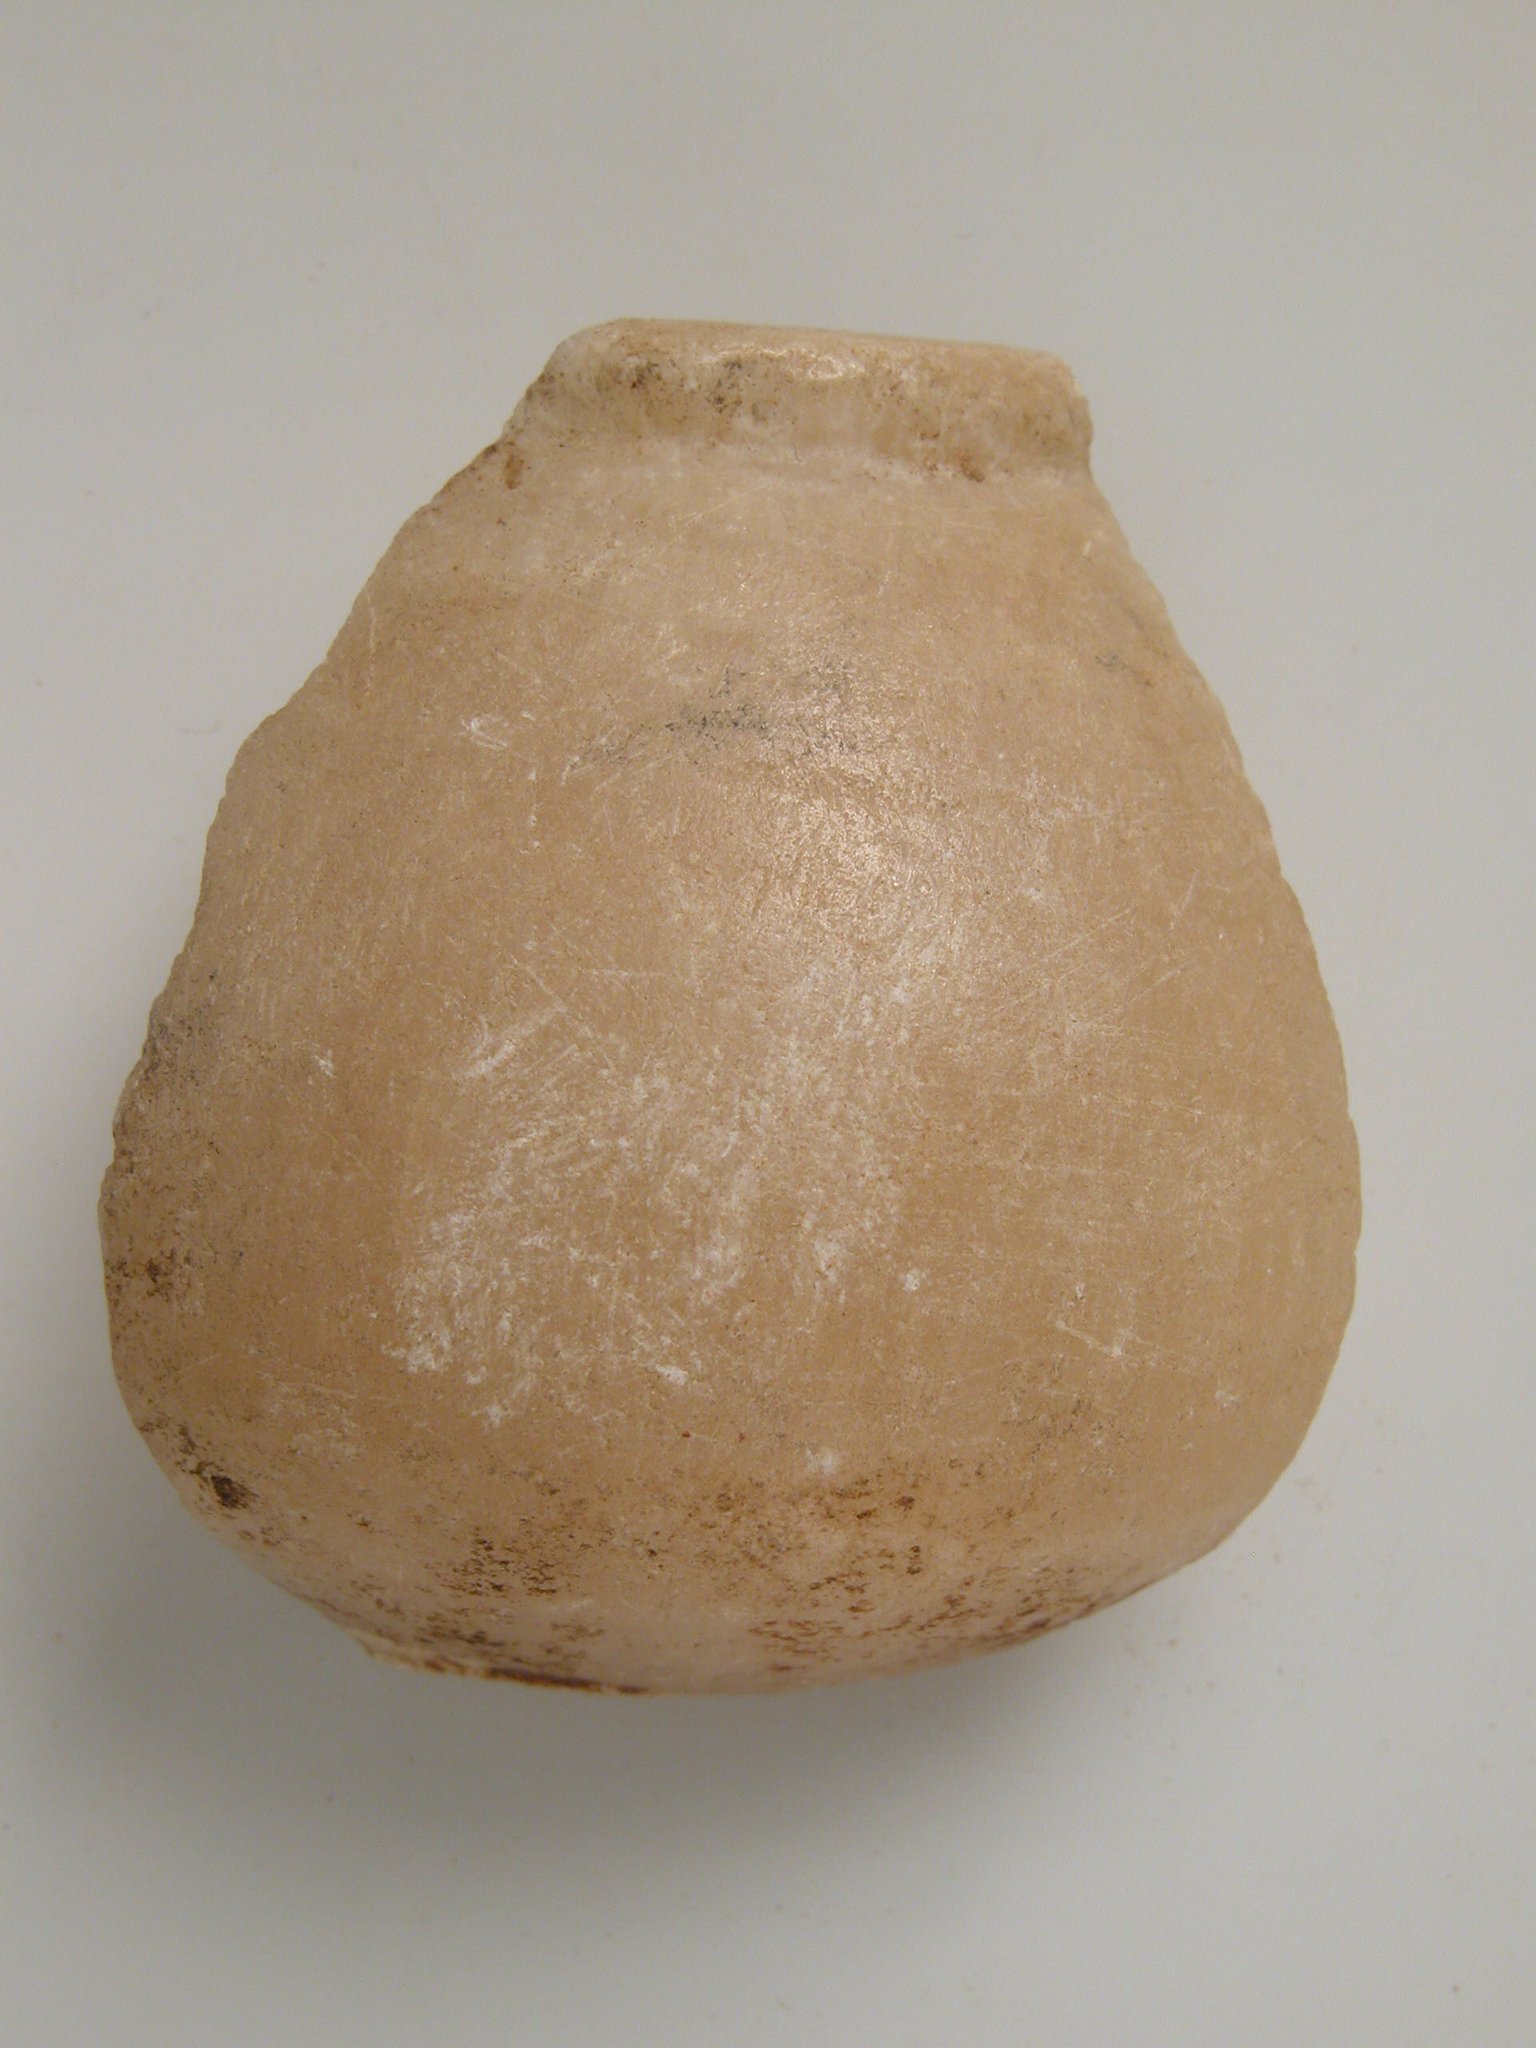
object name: fragment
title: Vessel Fragment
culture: coptic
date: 301-700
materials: alabaster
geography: egypt